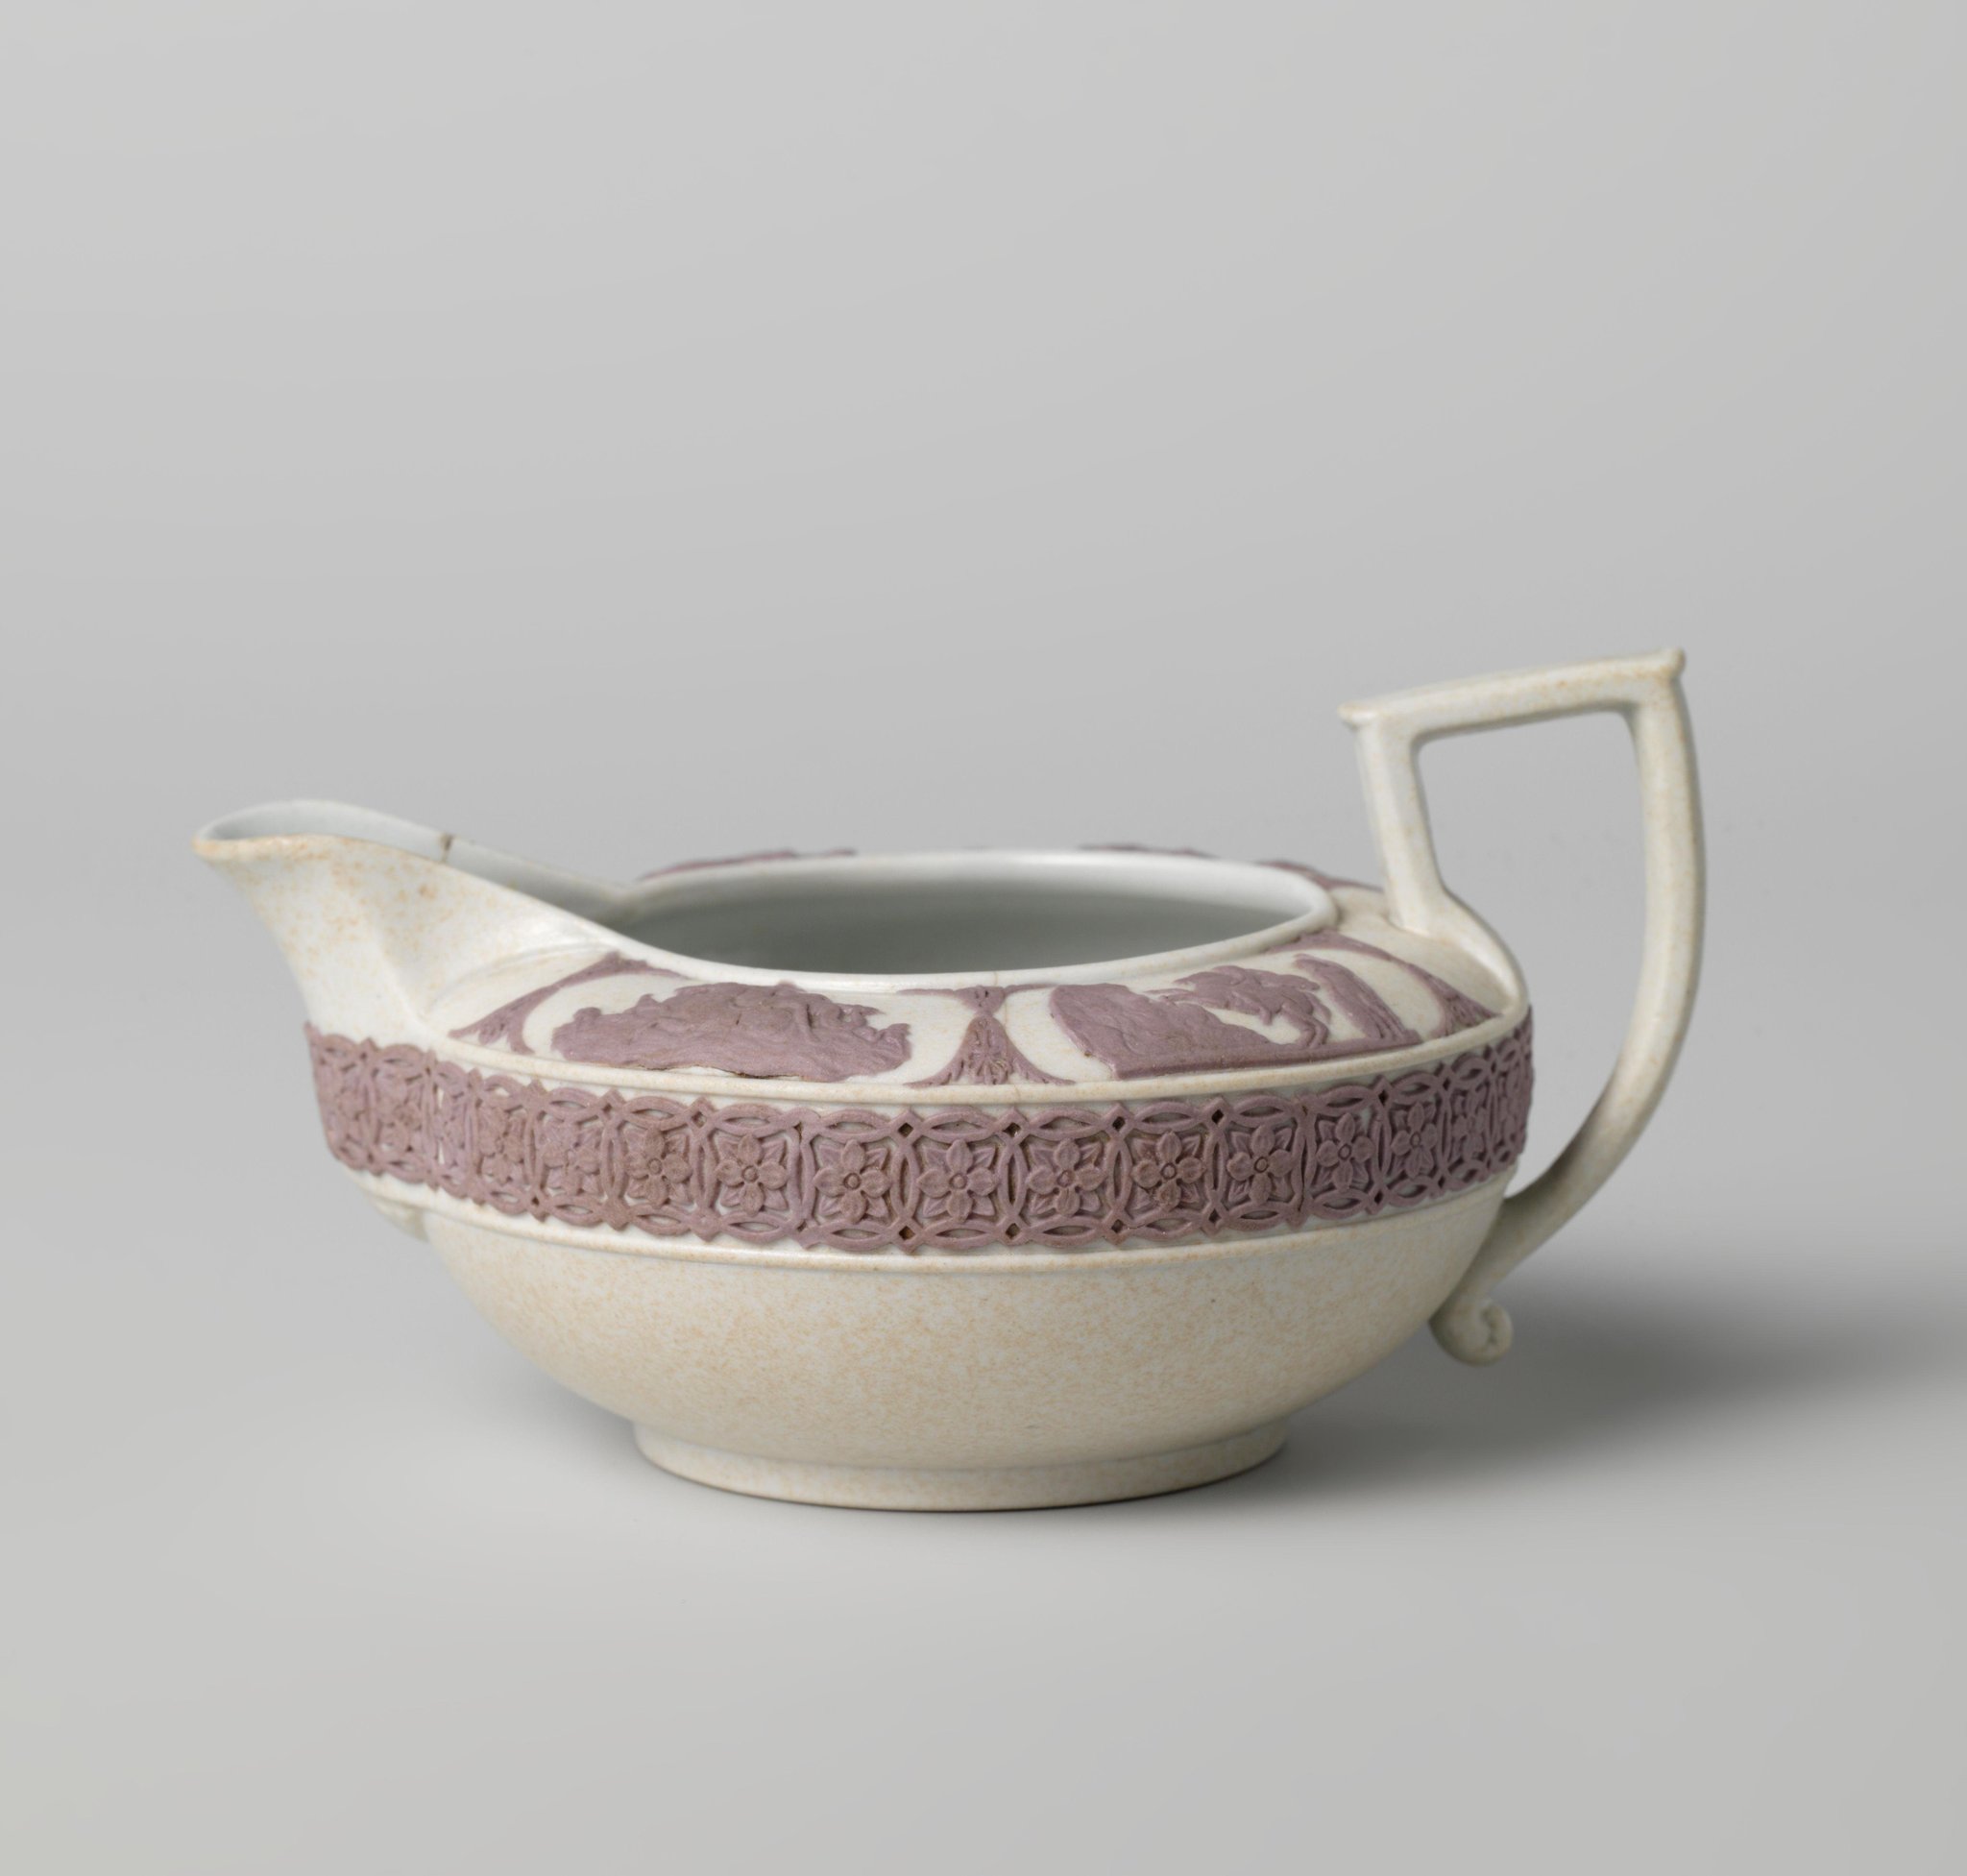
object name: ewer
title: Melkkan van steengoed, versierd met paarse applieken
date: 1790-1810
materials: stoneware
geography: england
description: Melkkan van gedecoreerd steengoed. De melkkan is ellipsvormig, heeft een schenktuit en een hoog opstaand rechthoekig oor. De melkkan is versierd met paarse applieken; op de bovenzijde vier mythologische voorstellingen en op de buik een ornamentrand met rozetten. De melkkan is gemerkt. Bij de melkkan hoort een suikerpot met invnr. BK-NM-13190-B.